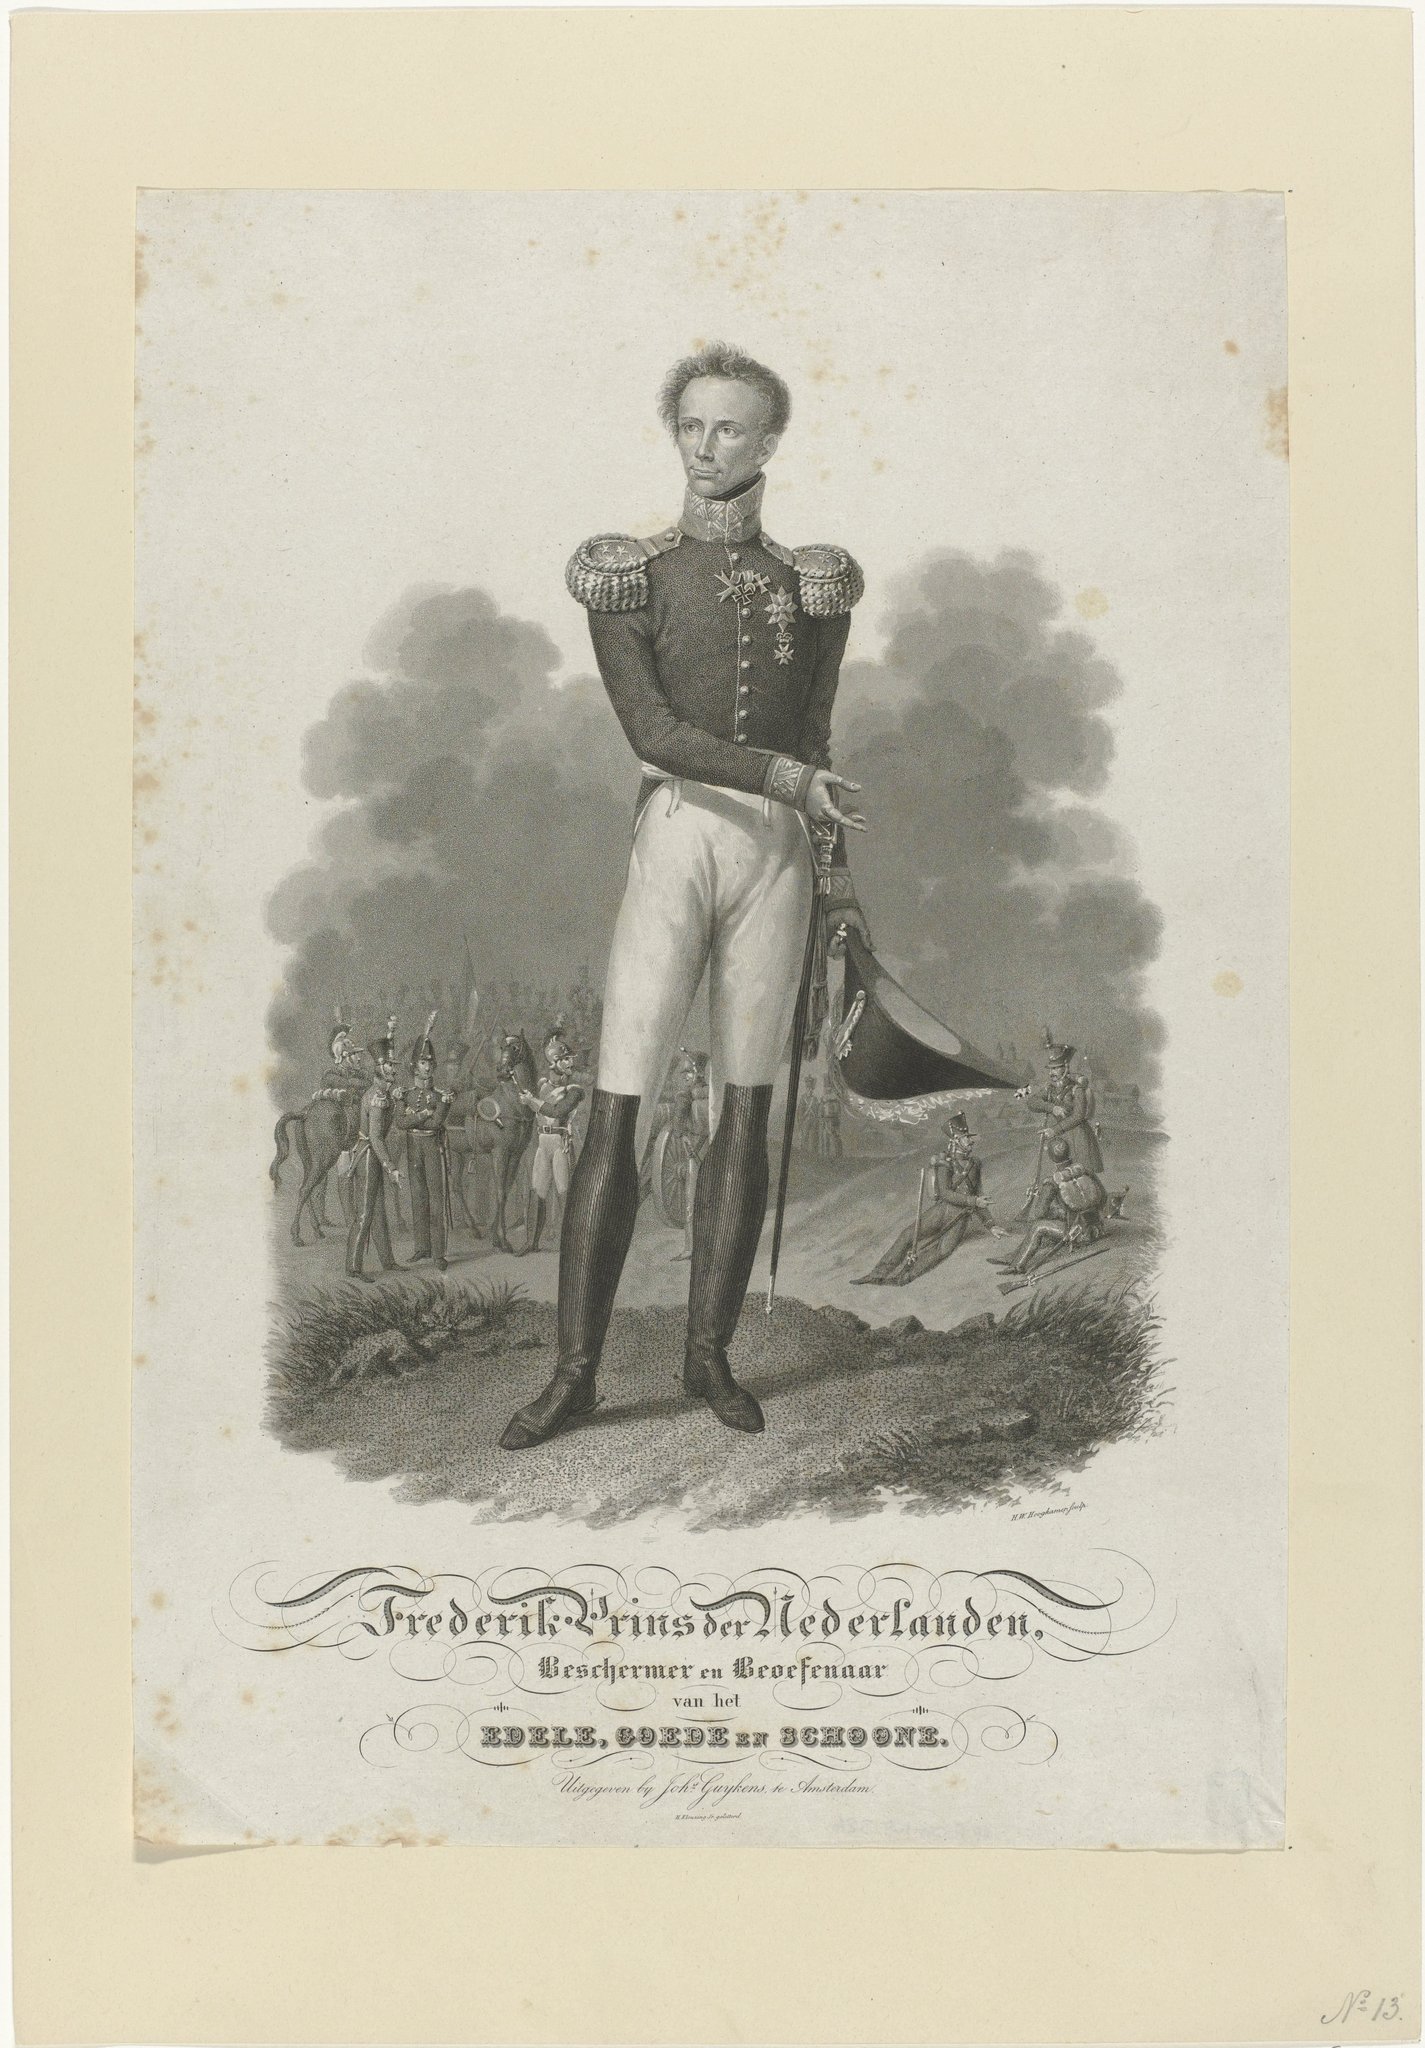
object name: print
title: Portret van Frederik, prins der Nederlanden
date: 1815-1864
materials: paper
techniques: aquatint, engraving, etching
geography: netherlands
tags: berlin, frederik (prins der nederlanden)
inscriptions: collector's mark: Lugt 963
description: De hier vermelde titel verwijst naar de hoogst verkregen titel van de geportretteerde, niet per se naar de titel die de geportretteerde op deze voorstelling draagt.